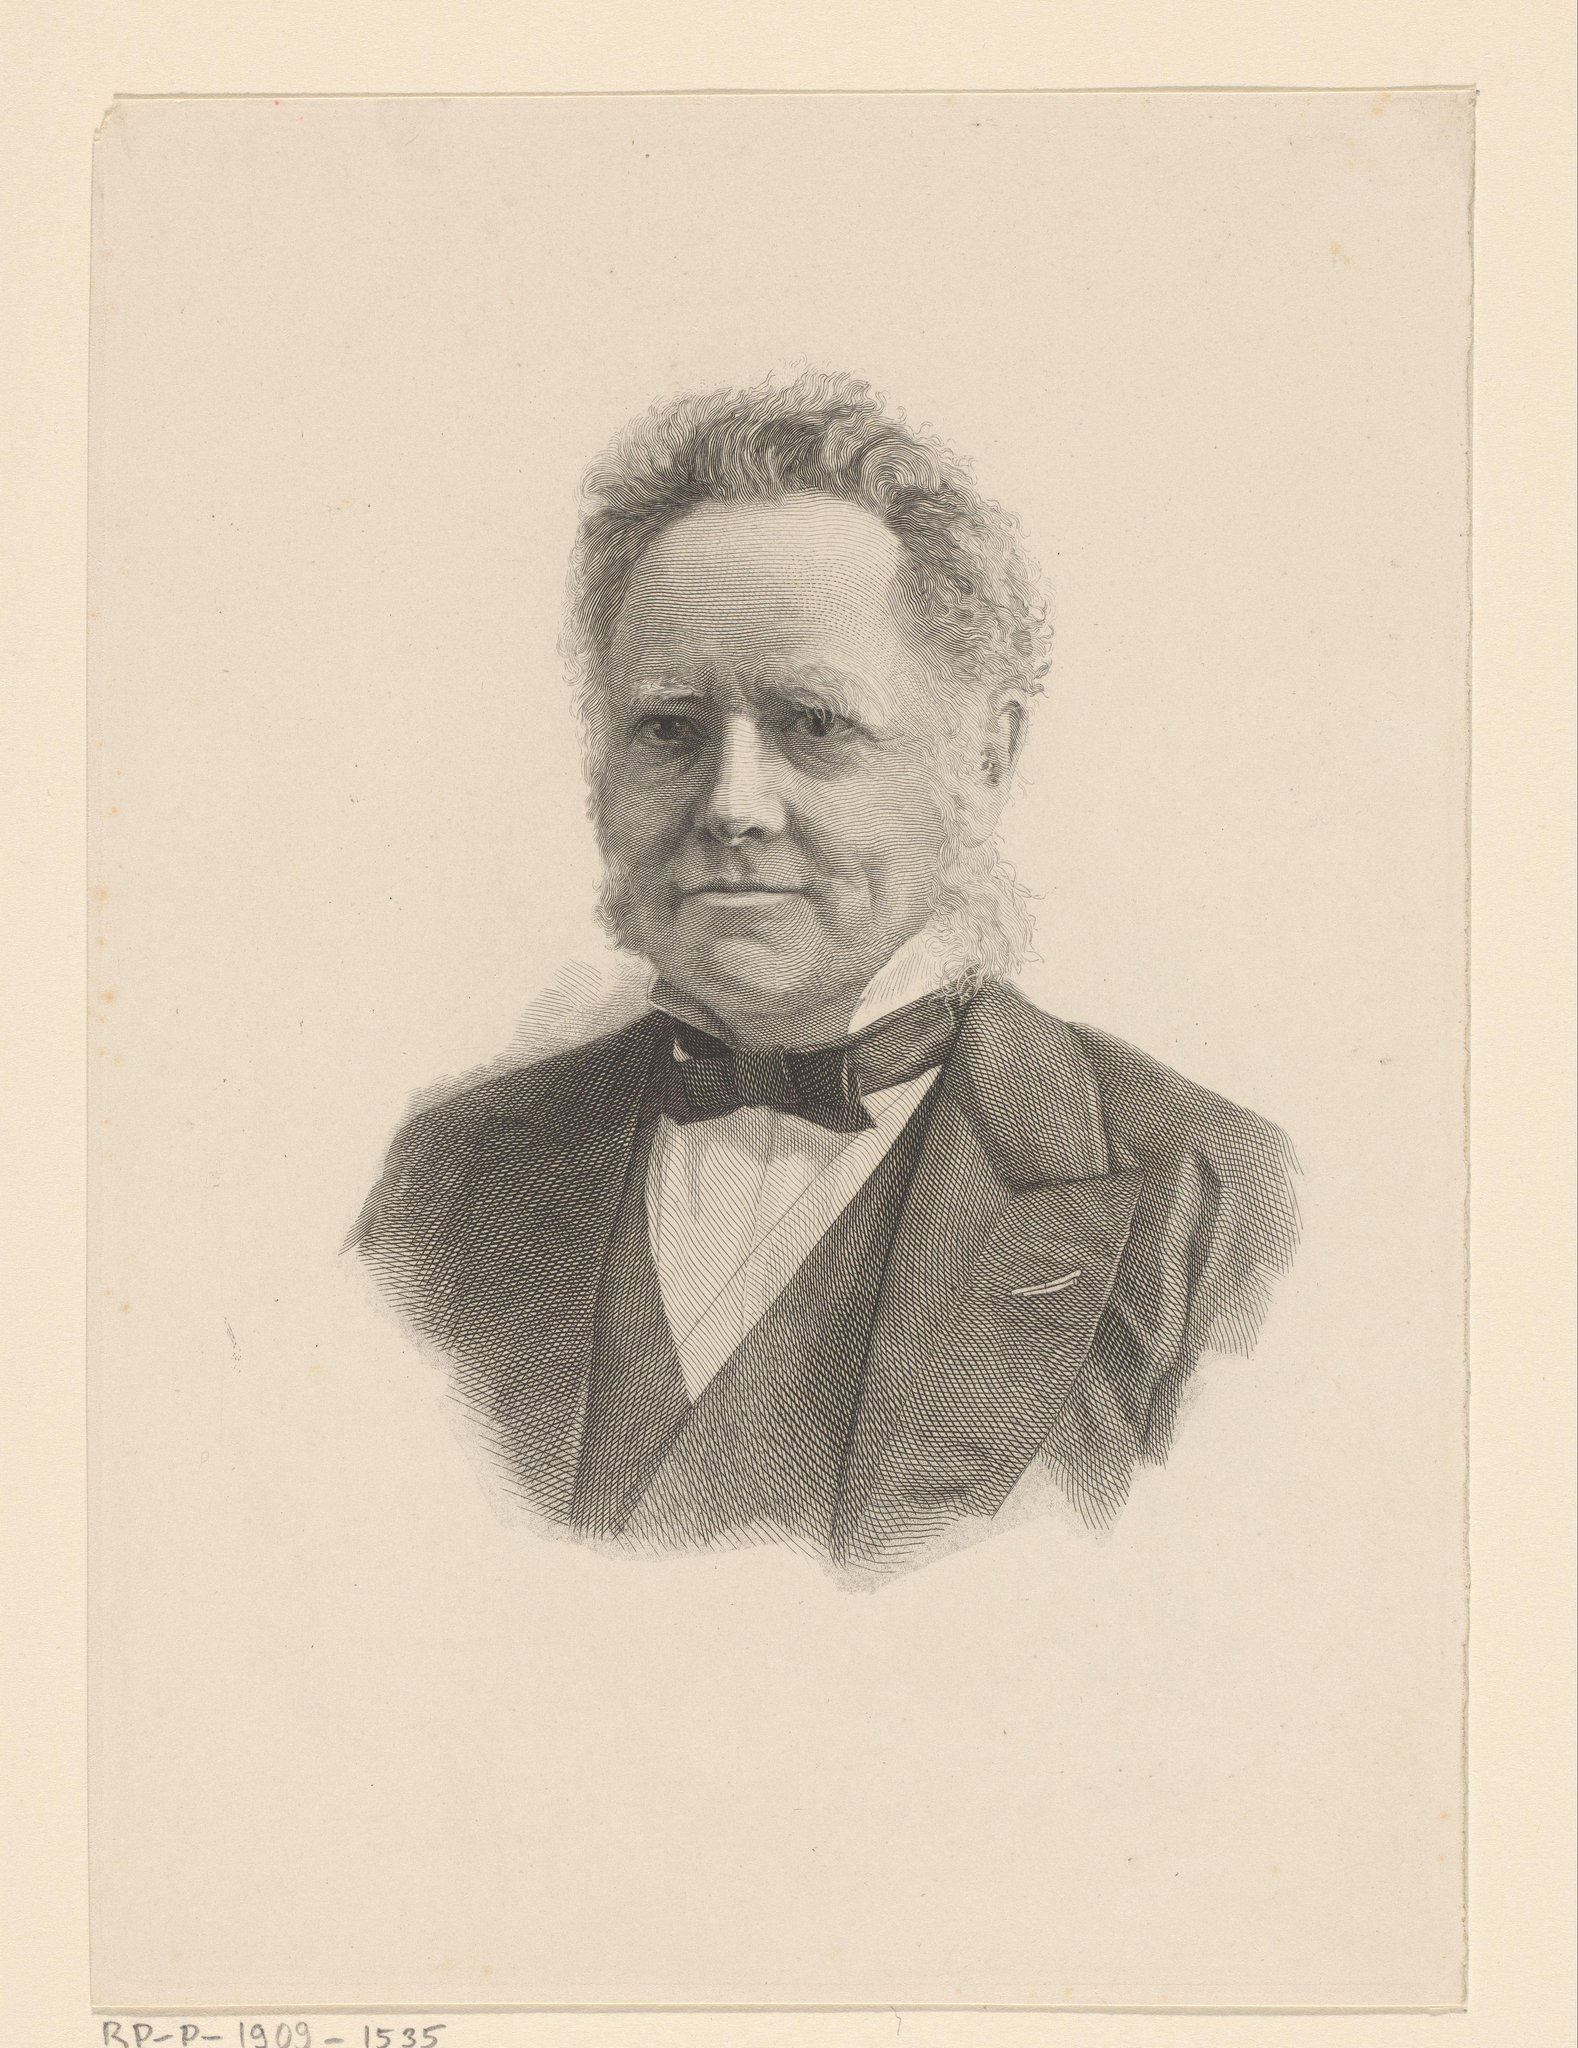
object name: print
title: Portret van een oudere man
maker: petrus johannes arendzen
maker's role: draughtsman, print maker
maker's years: 1846-1932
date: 1856-1900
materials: paper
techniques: engraving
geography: netherlands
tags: anonymous historical person portrayed alone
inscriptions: collector's mark: Lugt 2228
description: Borstbeeld van een onbekende oudere man.